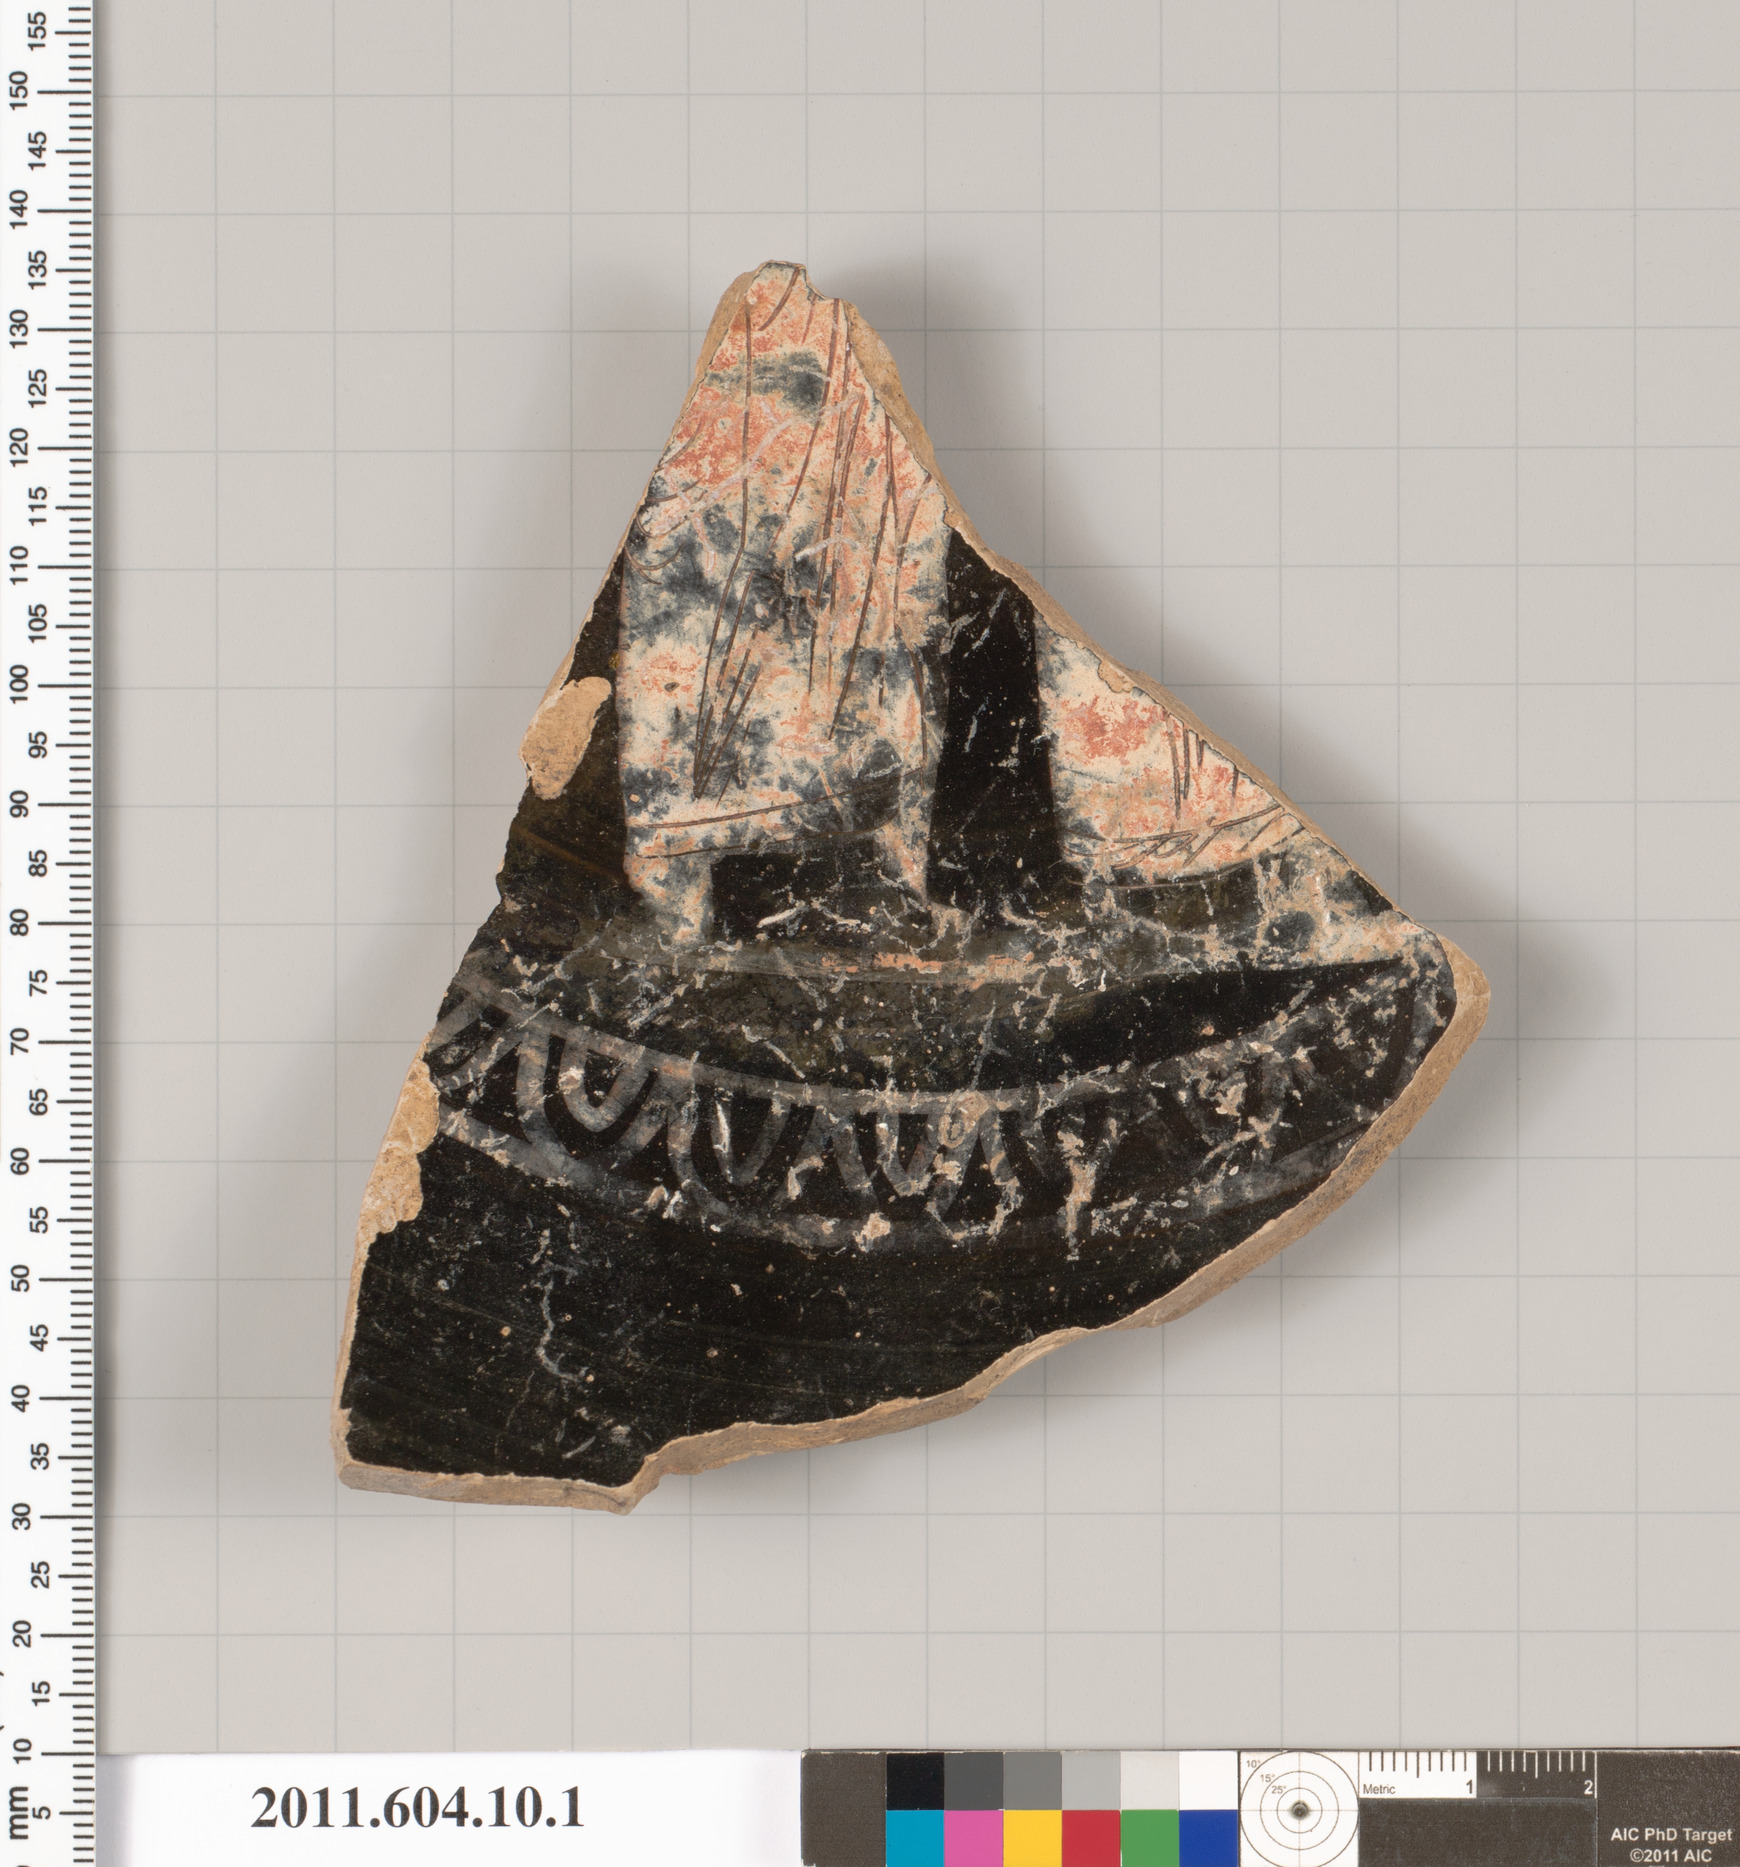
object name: kylix fragment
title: Terracotta fragment of a kylix (drinking cup)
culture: etruscan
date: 434-368 BCE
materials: terracotta